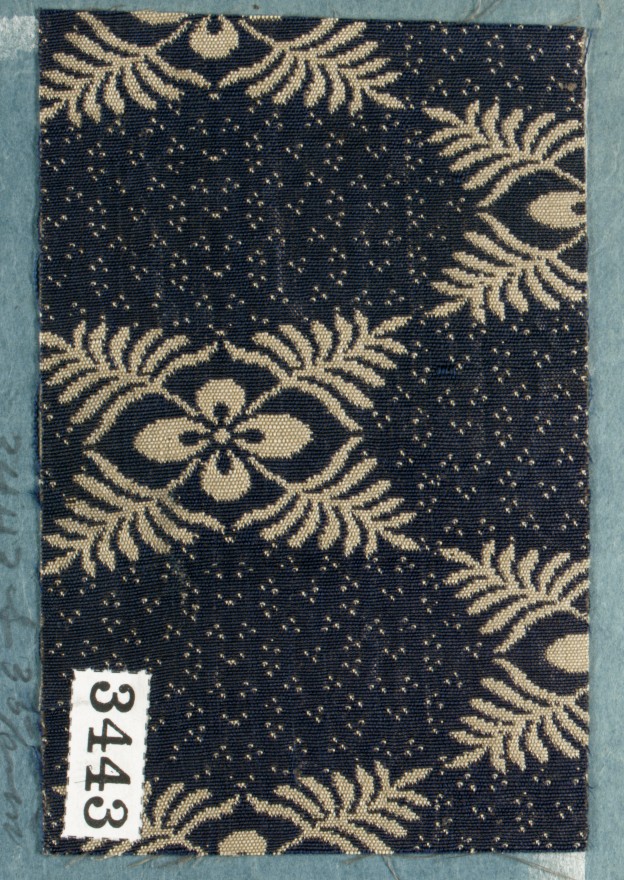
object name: textile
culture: japanese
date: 1801-1900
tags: leaves